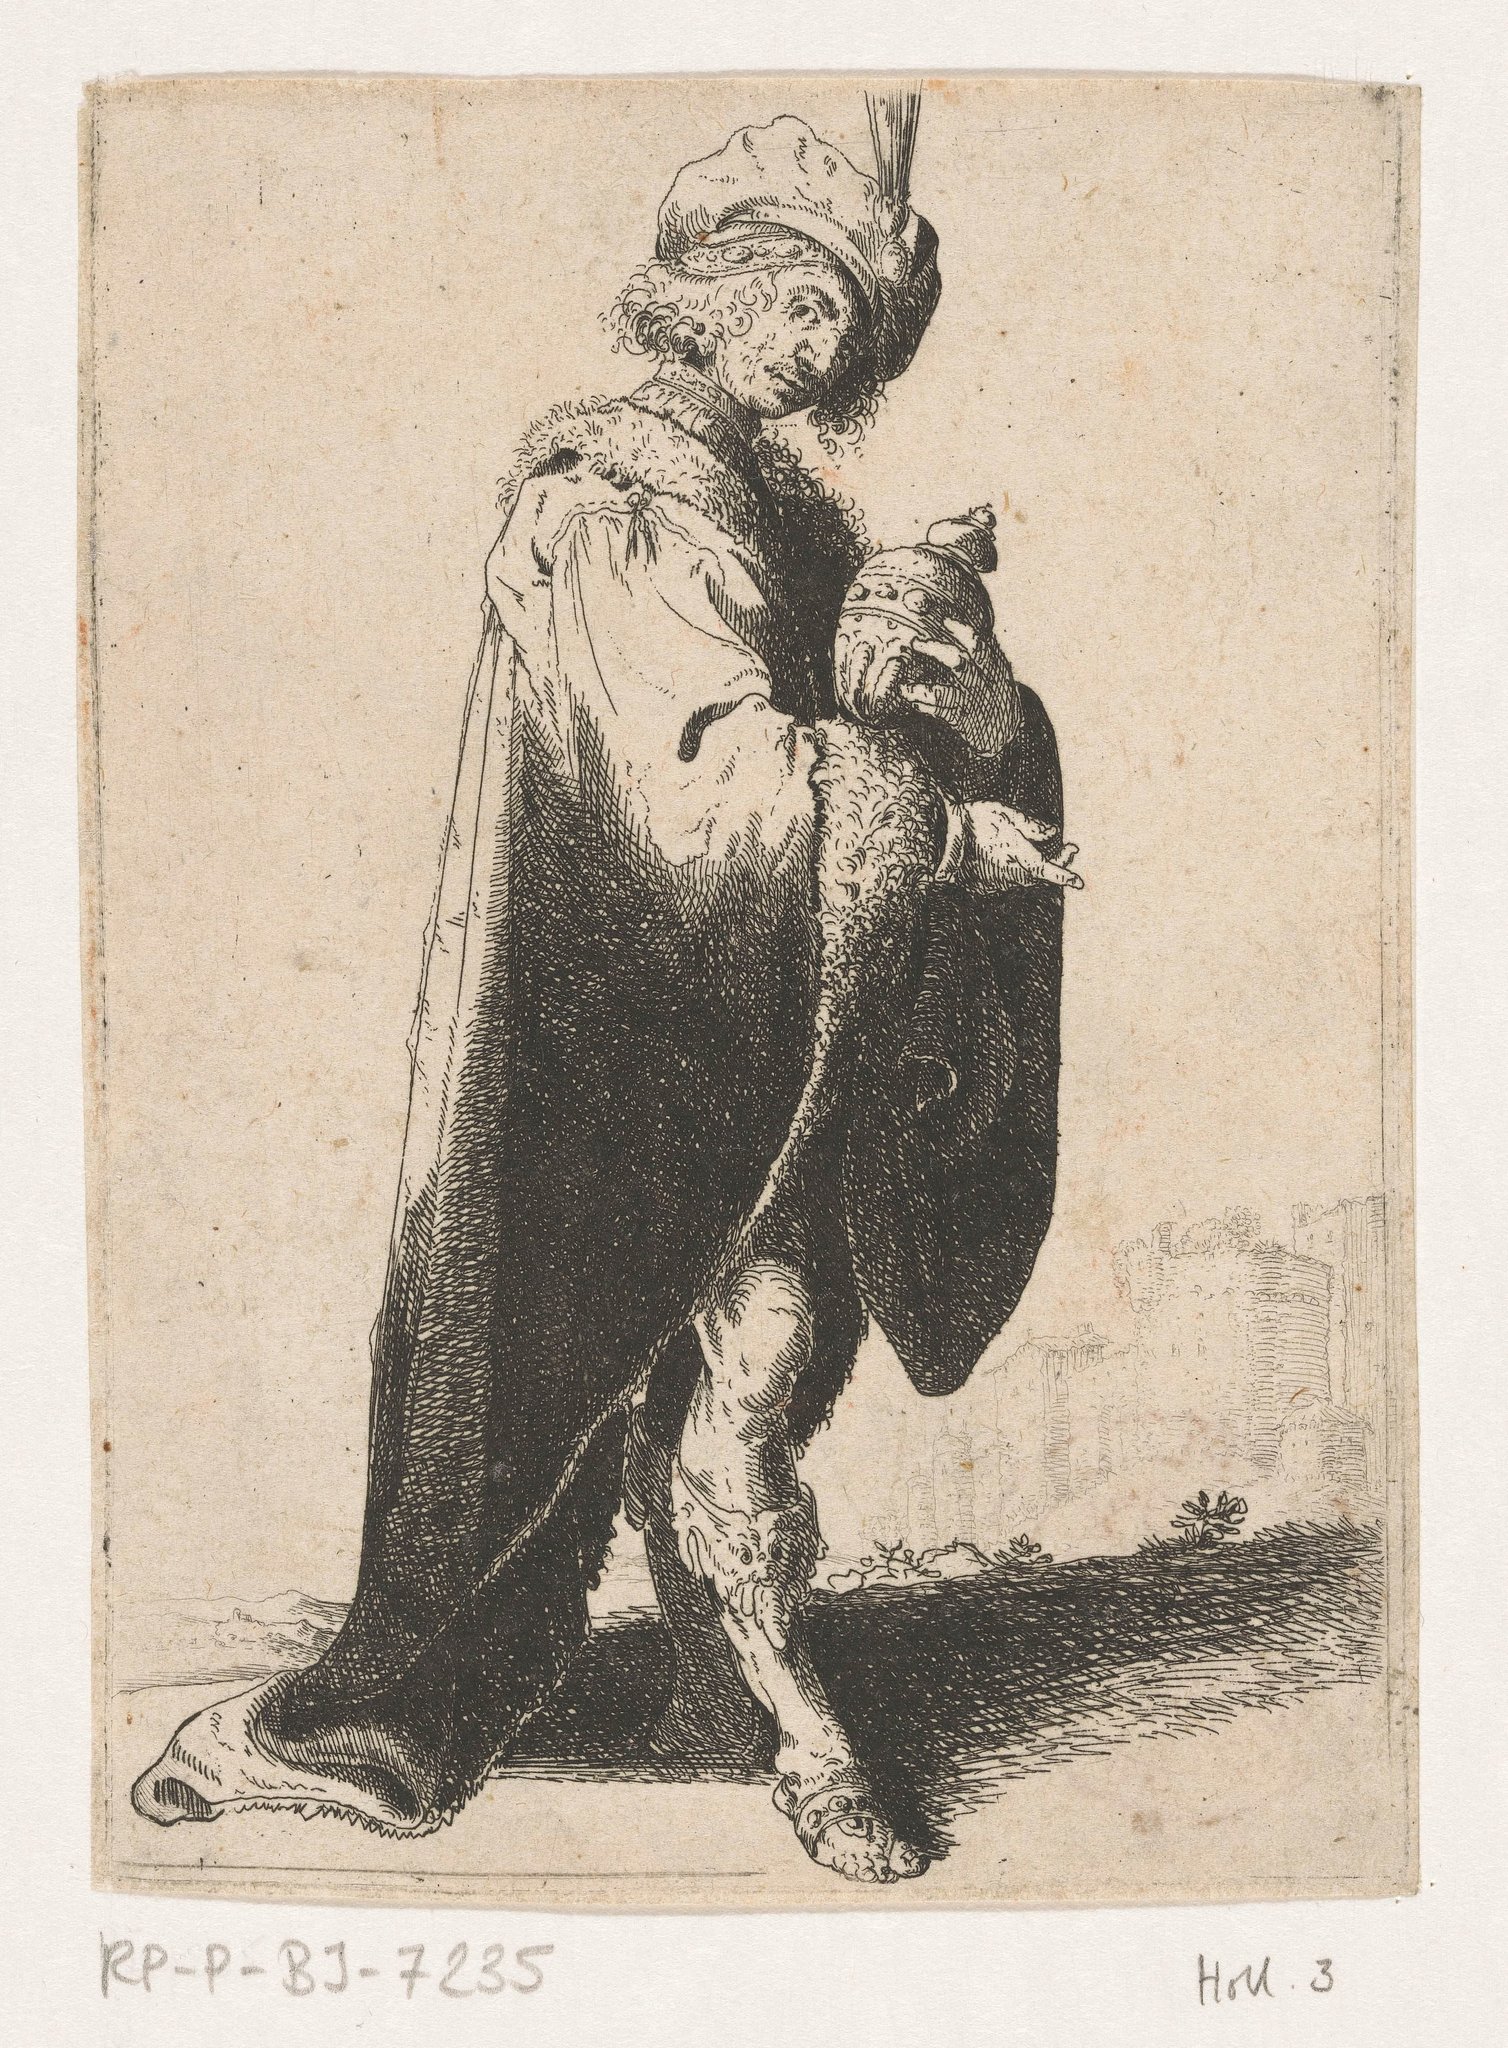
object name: print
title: Maria met Kind en de drie koningen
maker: jacob duck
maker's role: draughtsman, painter, print maker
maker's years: 1600-1667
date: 1621-1667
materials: paper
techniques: etching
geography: utrecht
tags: adoration of the kings: the wise men present their gifts to the christ-child (gold, frankincense and myrrh)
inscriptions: collector's mark: Lugt 240